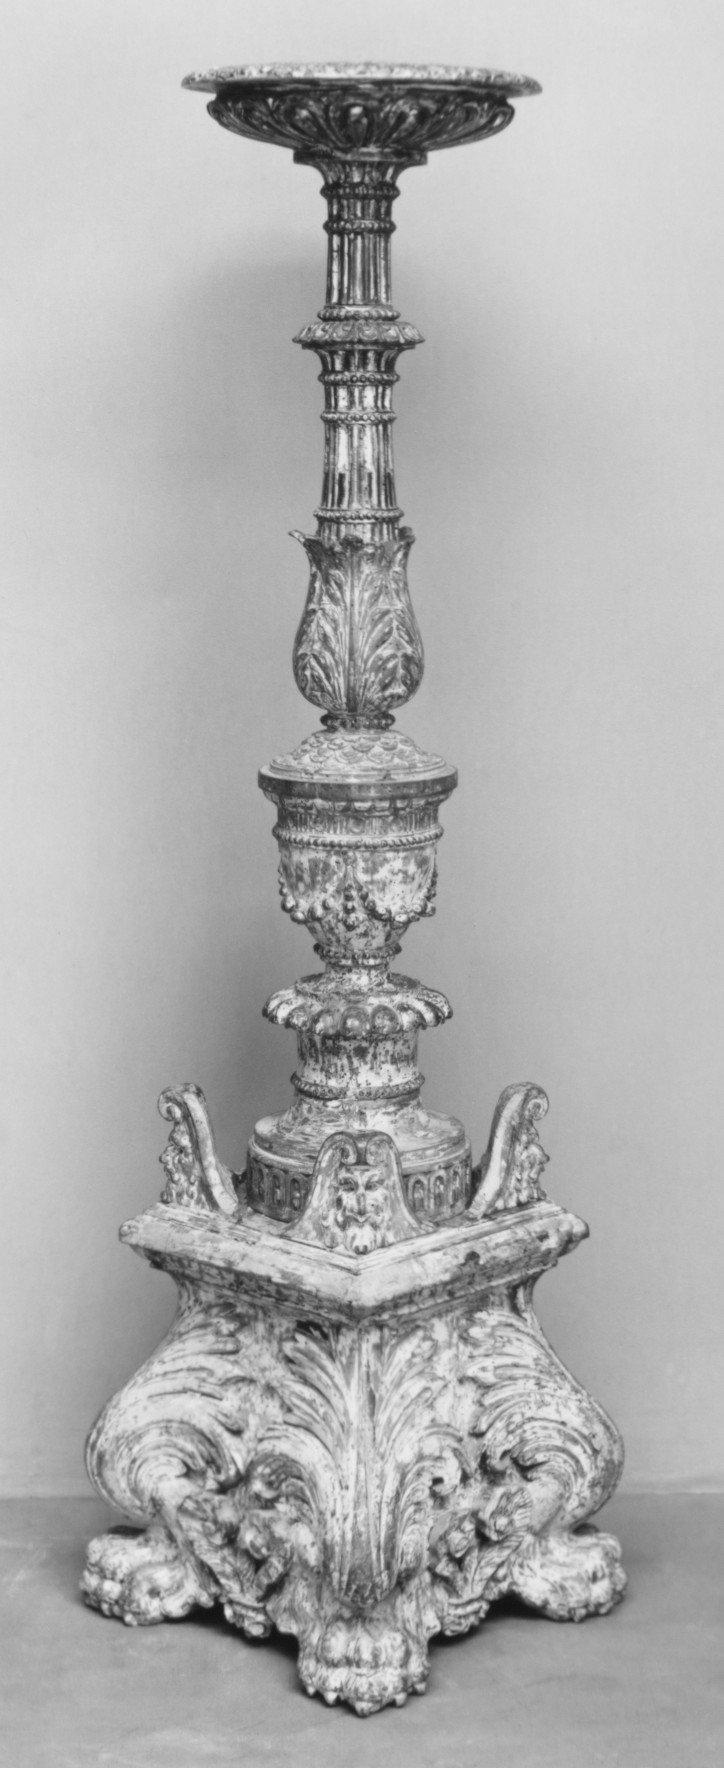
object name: candelabrum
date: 1501-1600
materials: wood